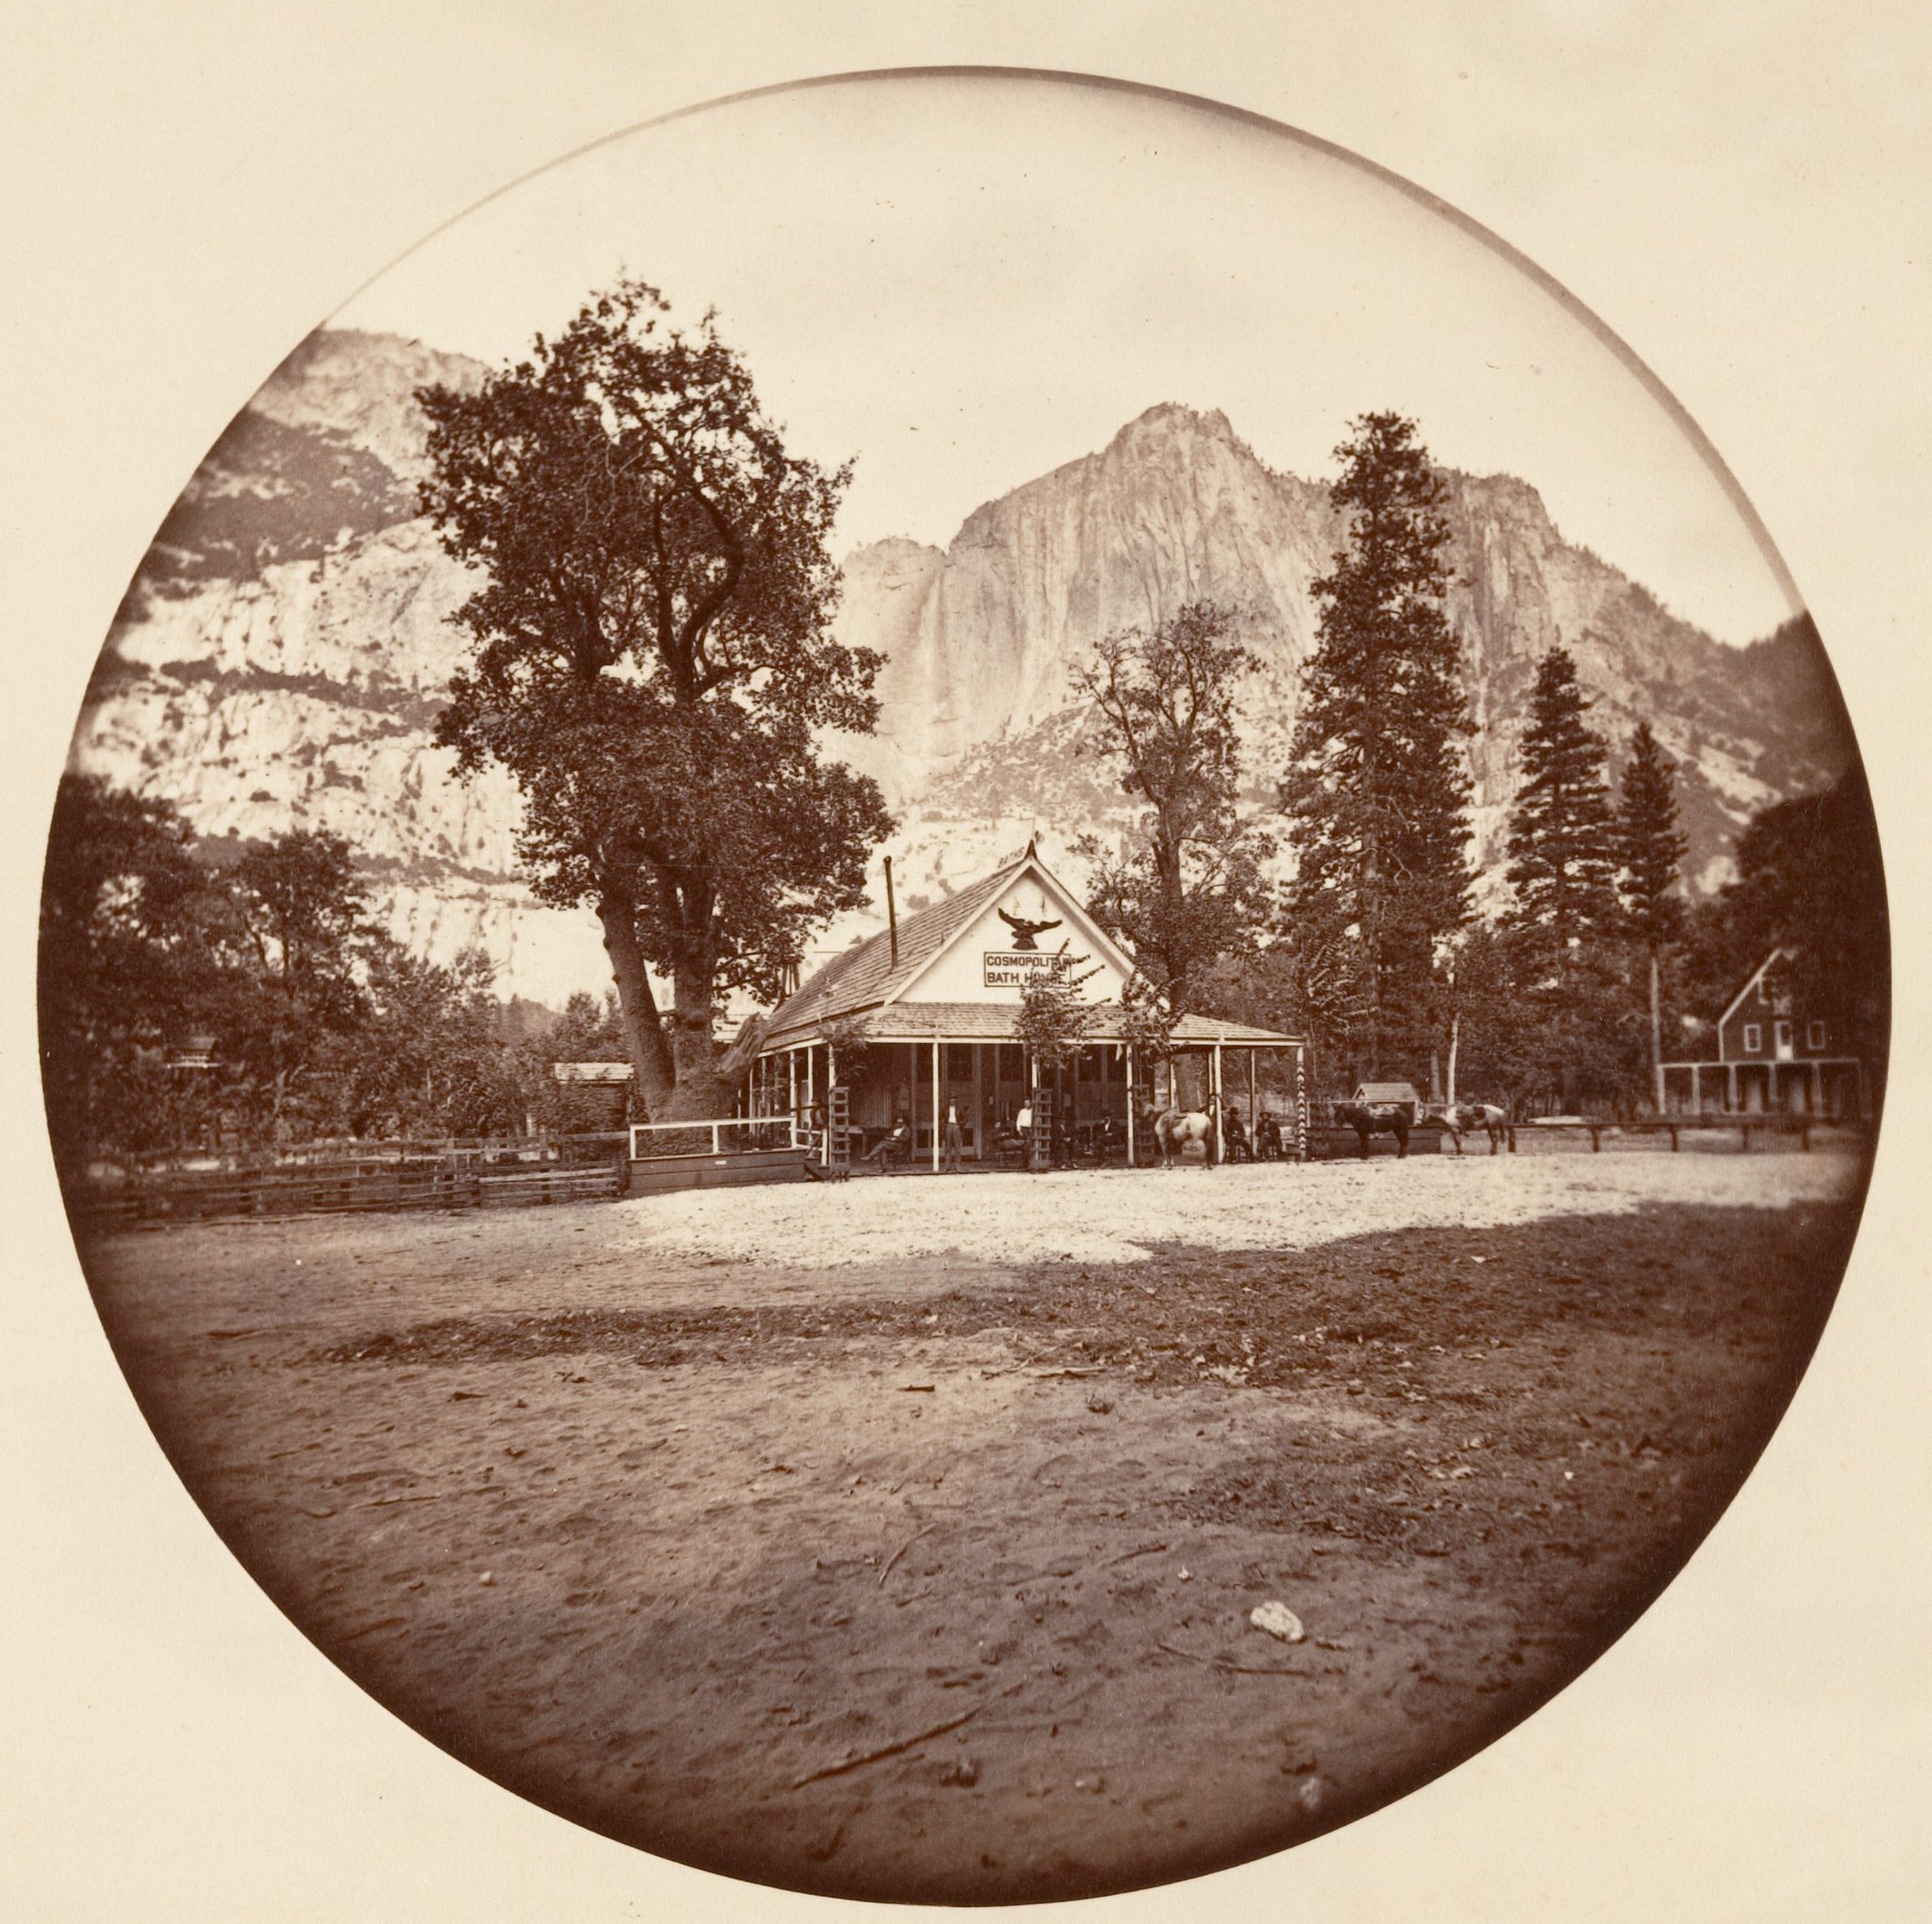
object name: photograph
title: [Yosemite National Park, California]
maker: carleton e. watkins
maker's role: artist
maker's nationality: american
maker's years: 1829-1916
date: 1878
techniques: albumen silver print, glass negative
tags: buildings,horses,mountains,landscapes